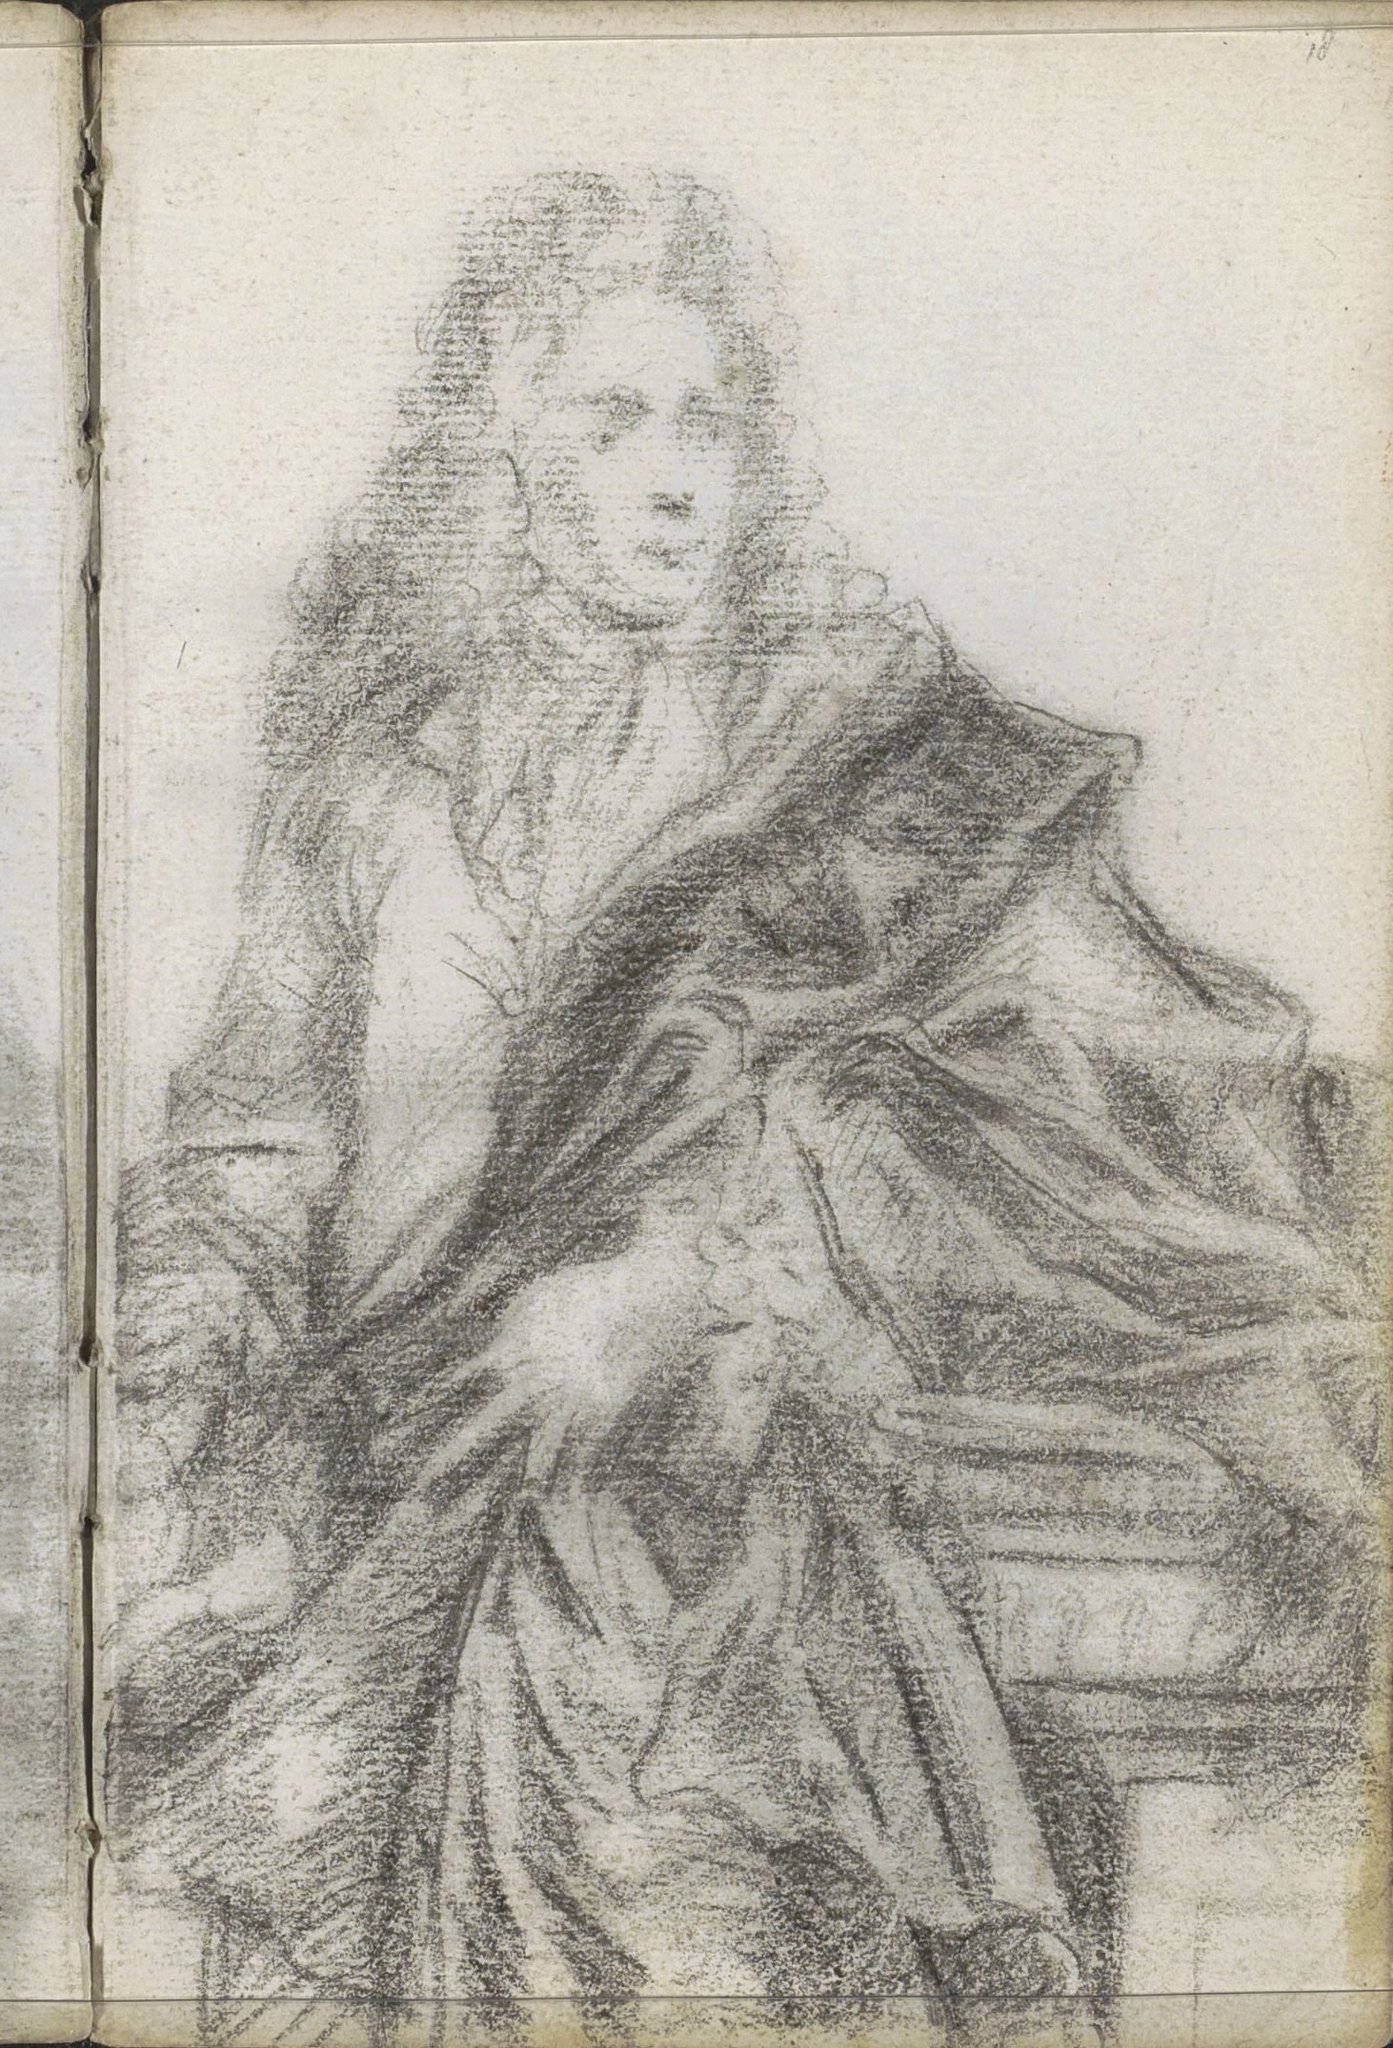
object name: sketchbook leaf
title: Portret van een man leunend op een pilaar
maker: petrus johannes van reysschoot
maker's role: draughtsman, print maker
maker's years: 1702-1772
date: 1710-1772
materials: chalk, paper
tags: anonymous historical person portrayed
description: Blad 18 recto uit een schetsboek met 105 bladen.